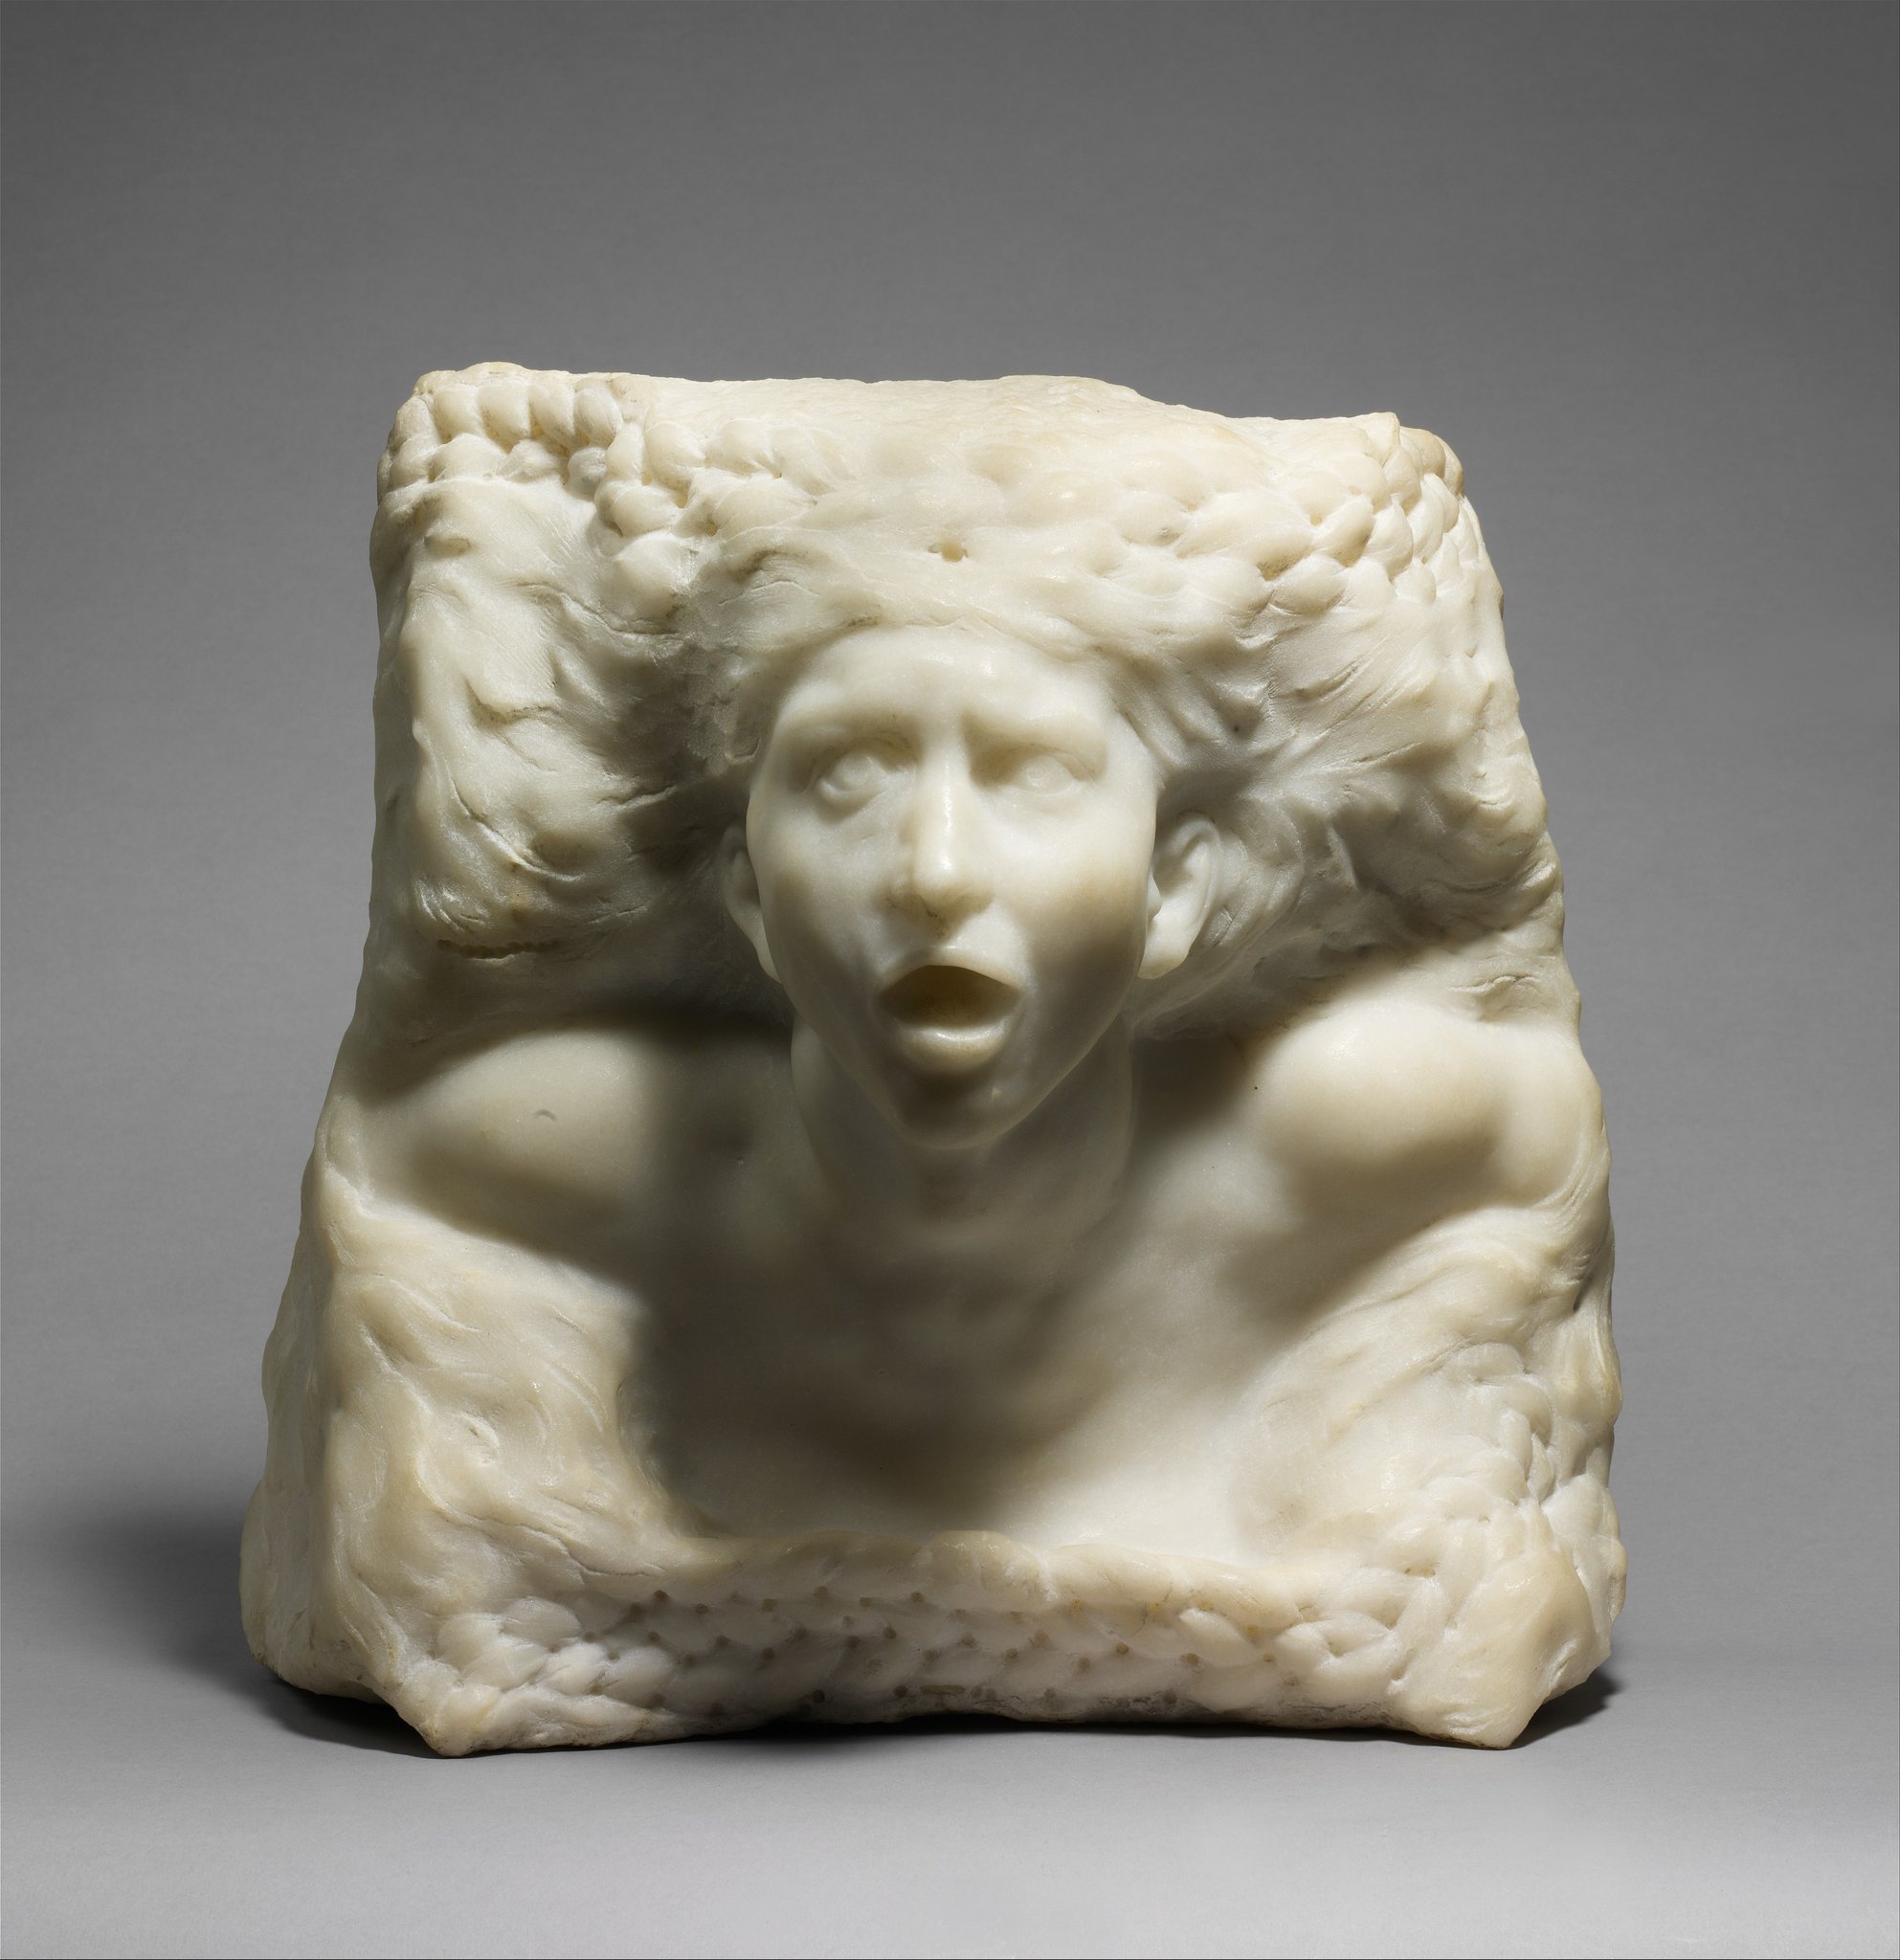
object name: relief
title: The Tempest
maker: auguste rodin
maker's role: artist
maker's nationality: french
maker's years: 1840-1917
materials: marble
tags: faces,women